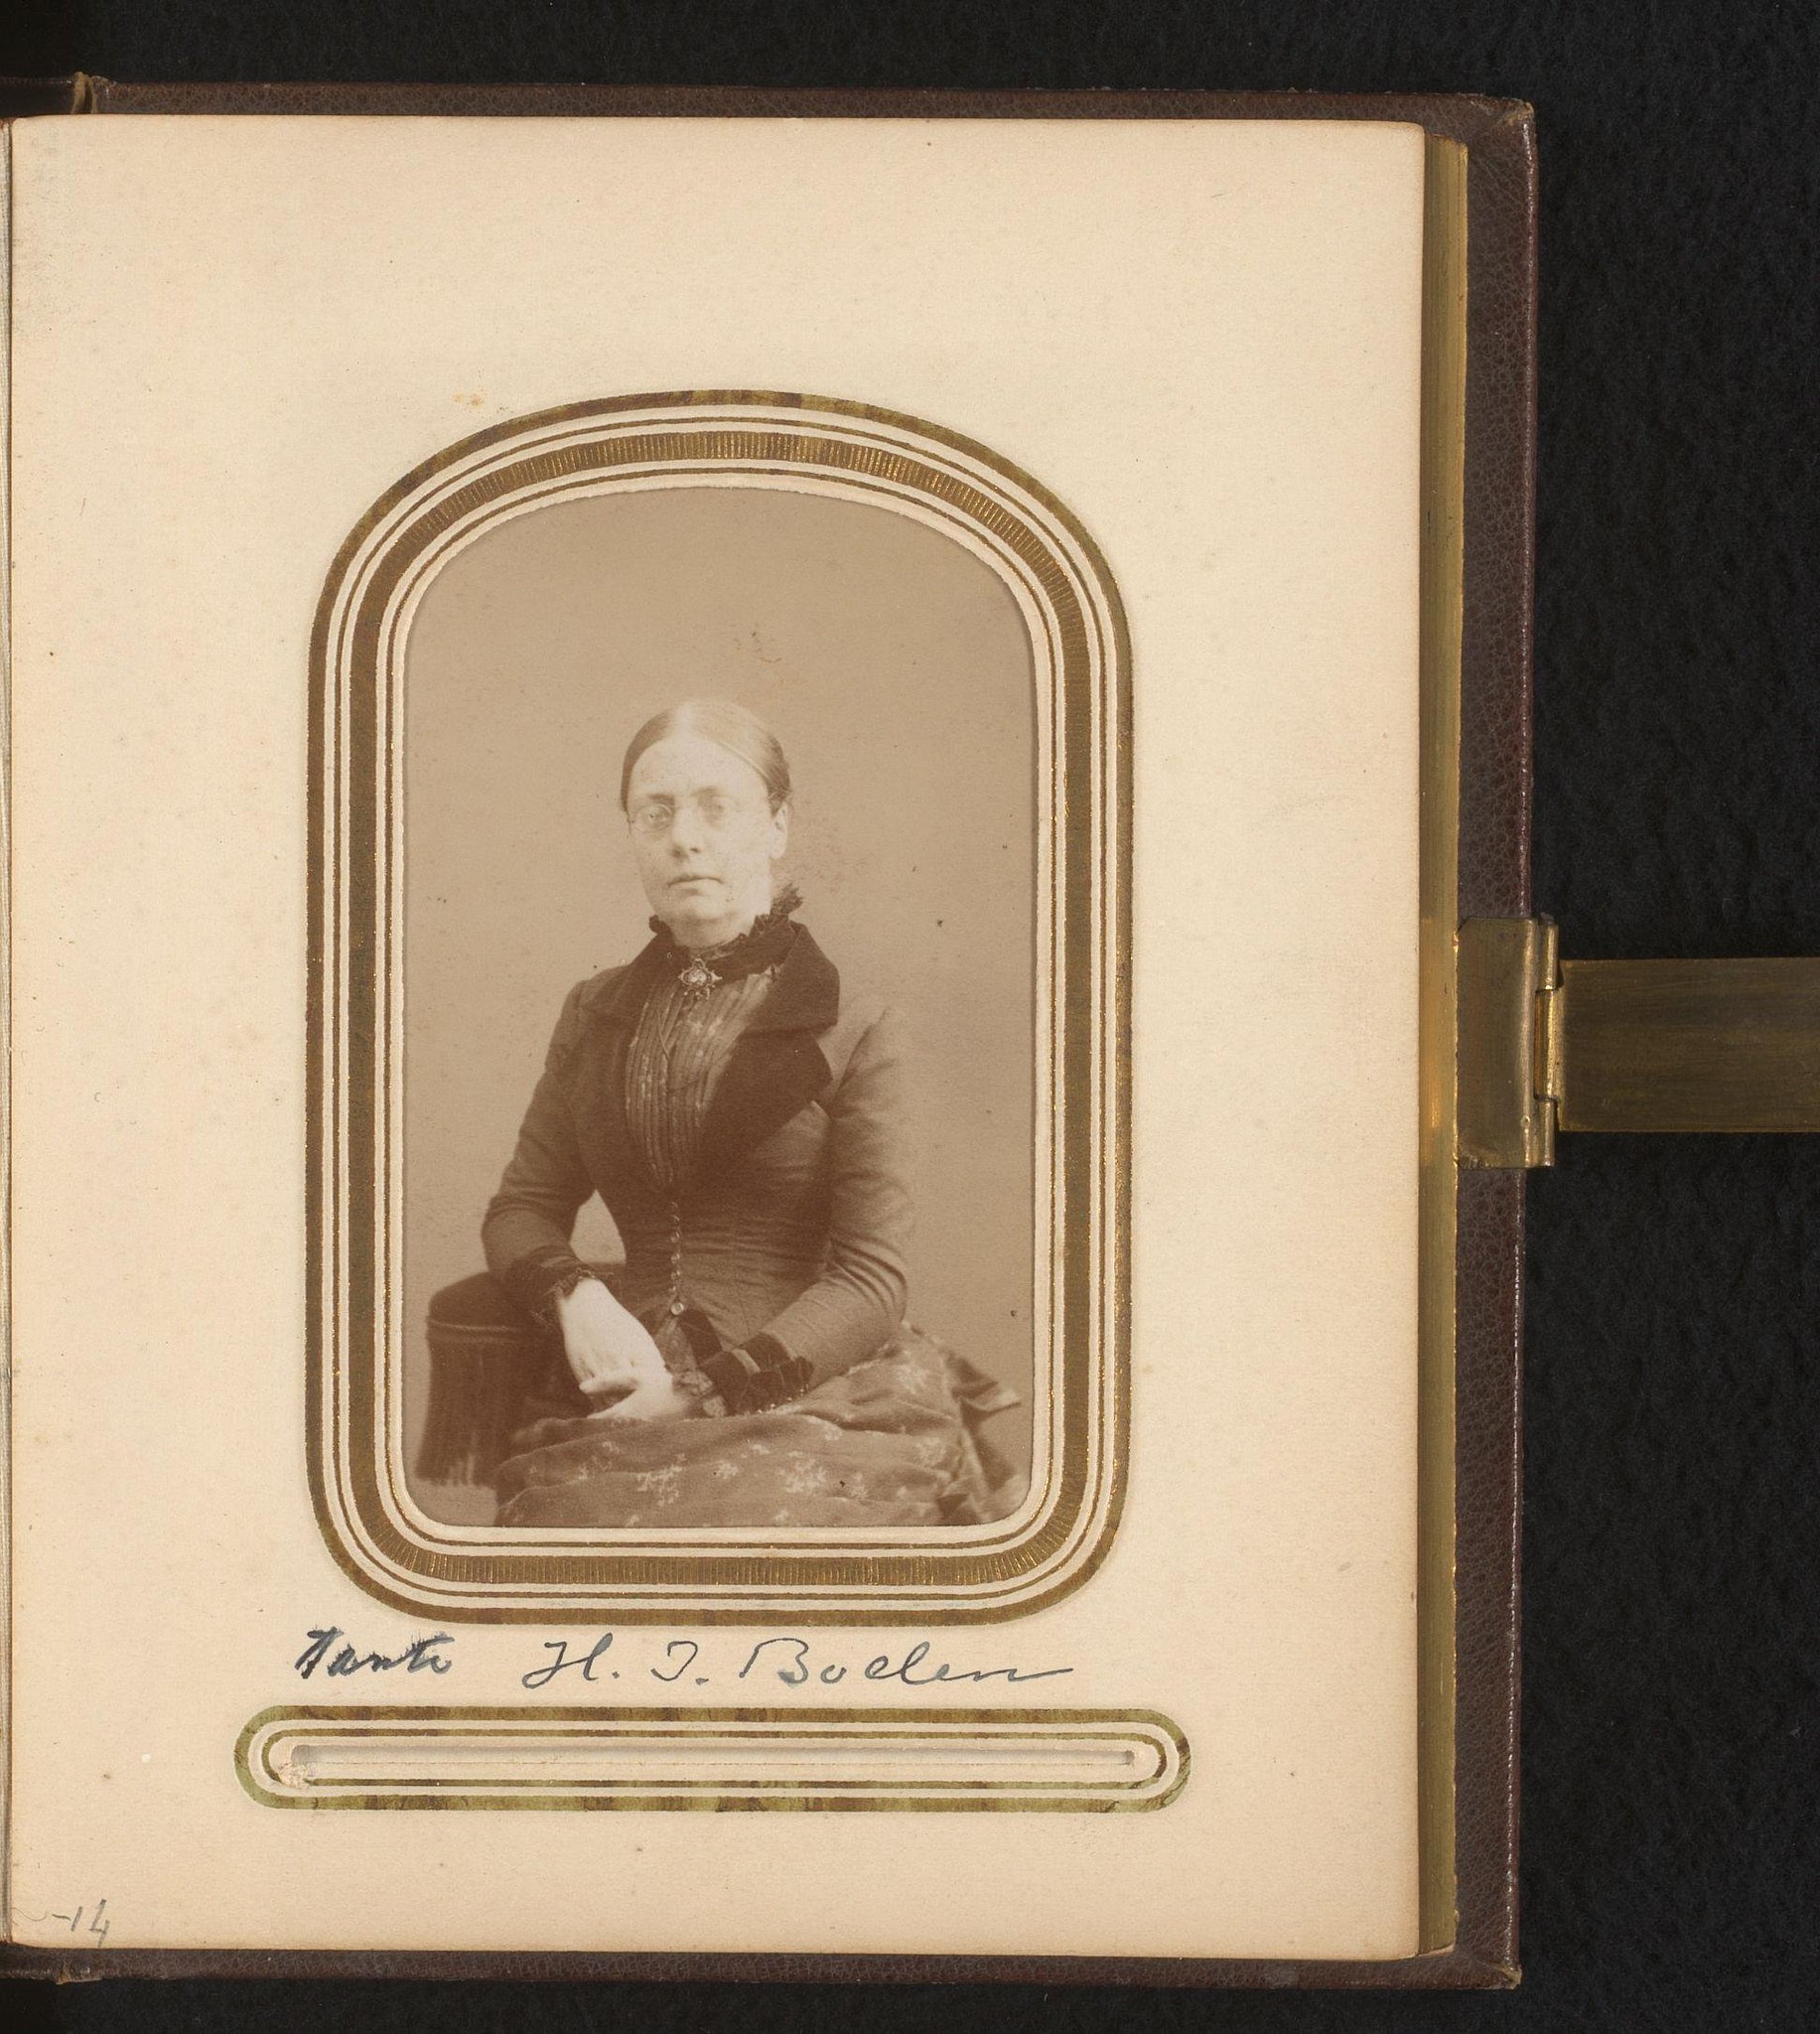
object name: album leaf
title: Tante H.J. Boelen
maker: johannes petrus oppers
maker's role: fotograaf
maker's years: 1833-1890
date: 1869-1890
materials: cardboard, paper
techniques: albumen print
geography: amsterdam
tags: historical persons - bb - woman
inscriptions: address: ‘KALVERSTRAAT, E 103/ AMSTERDAM.’